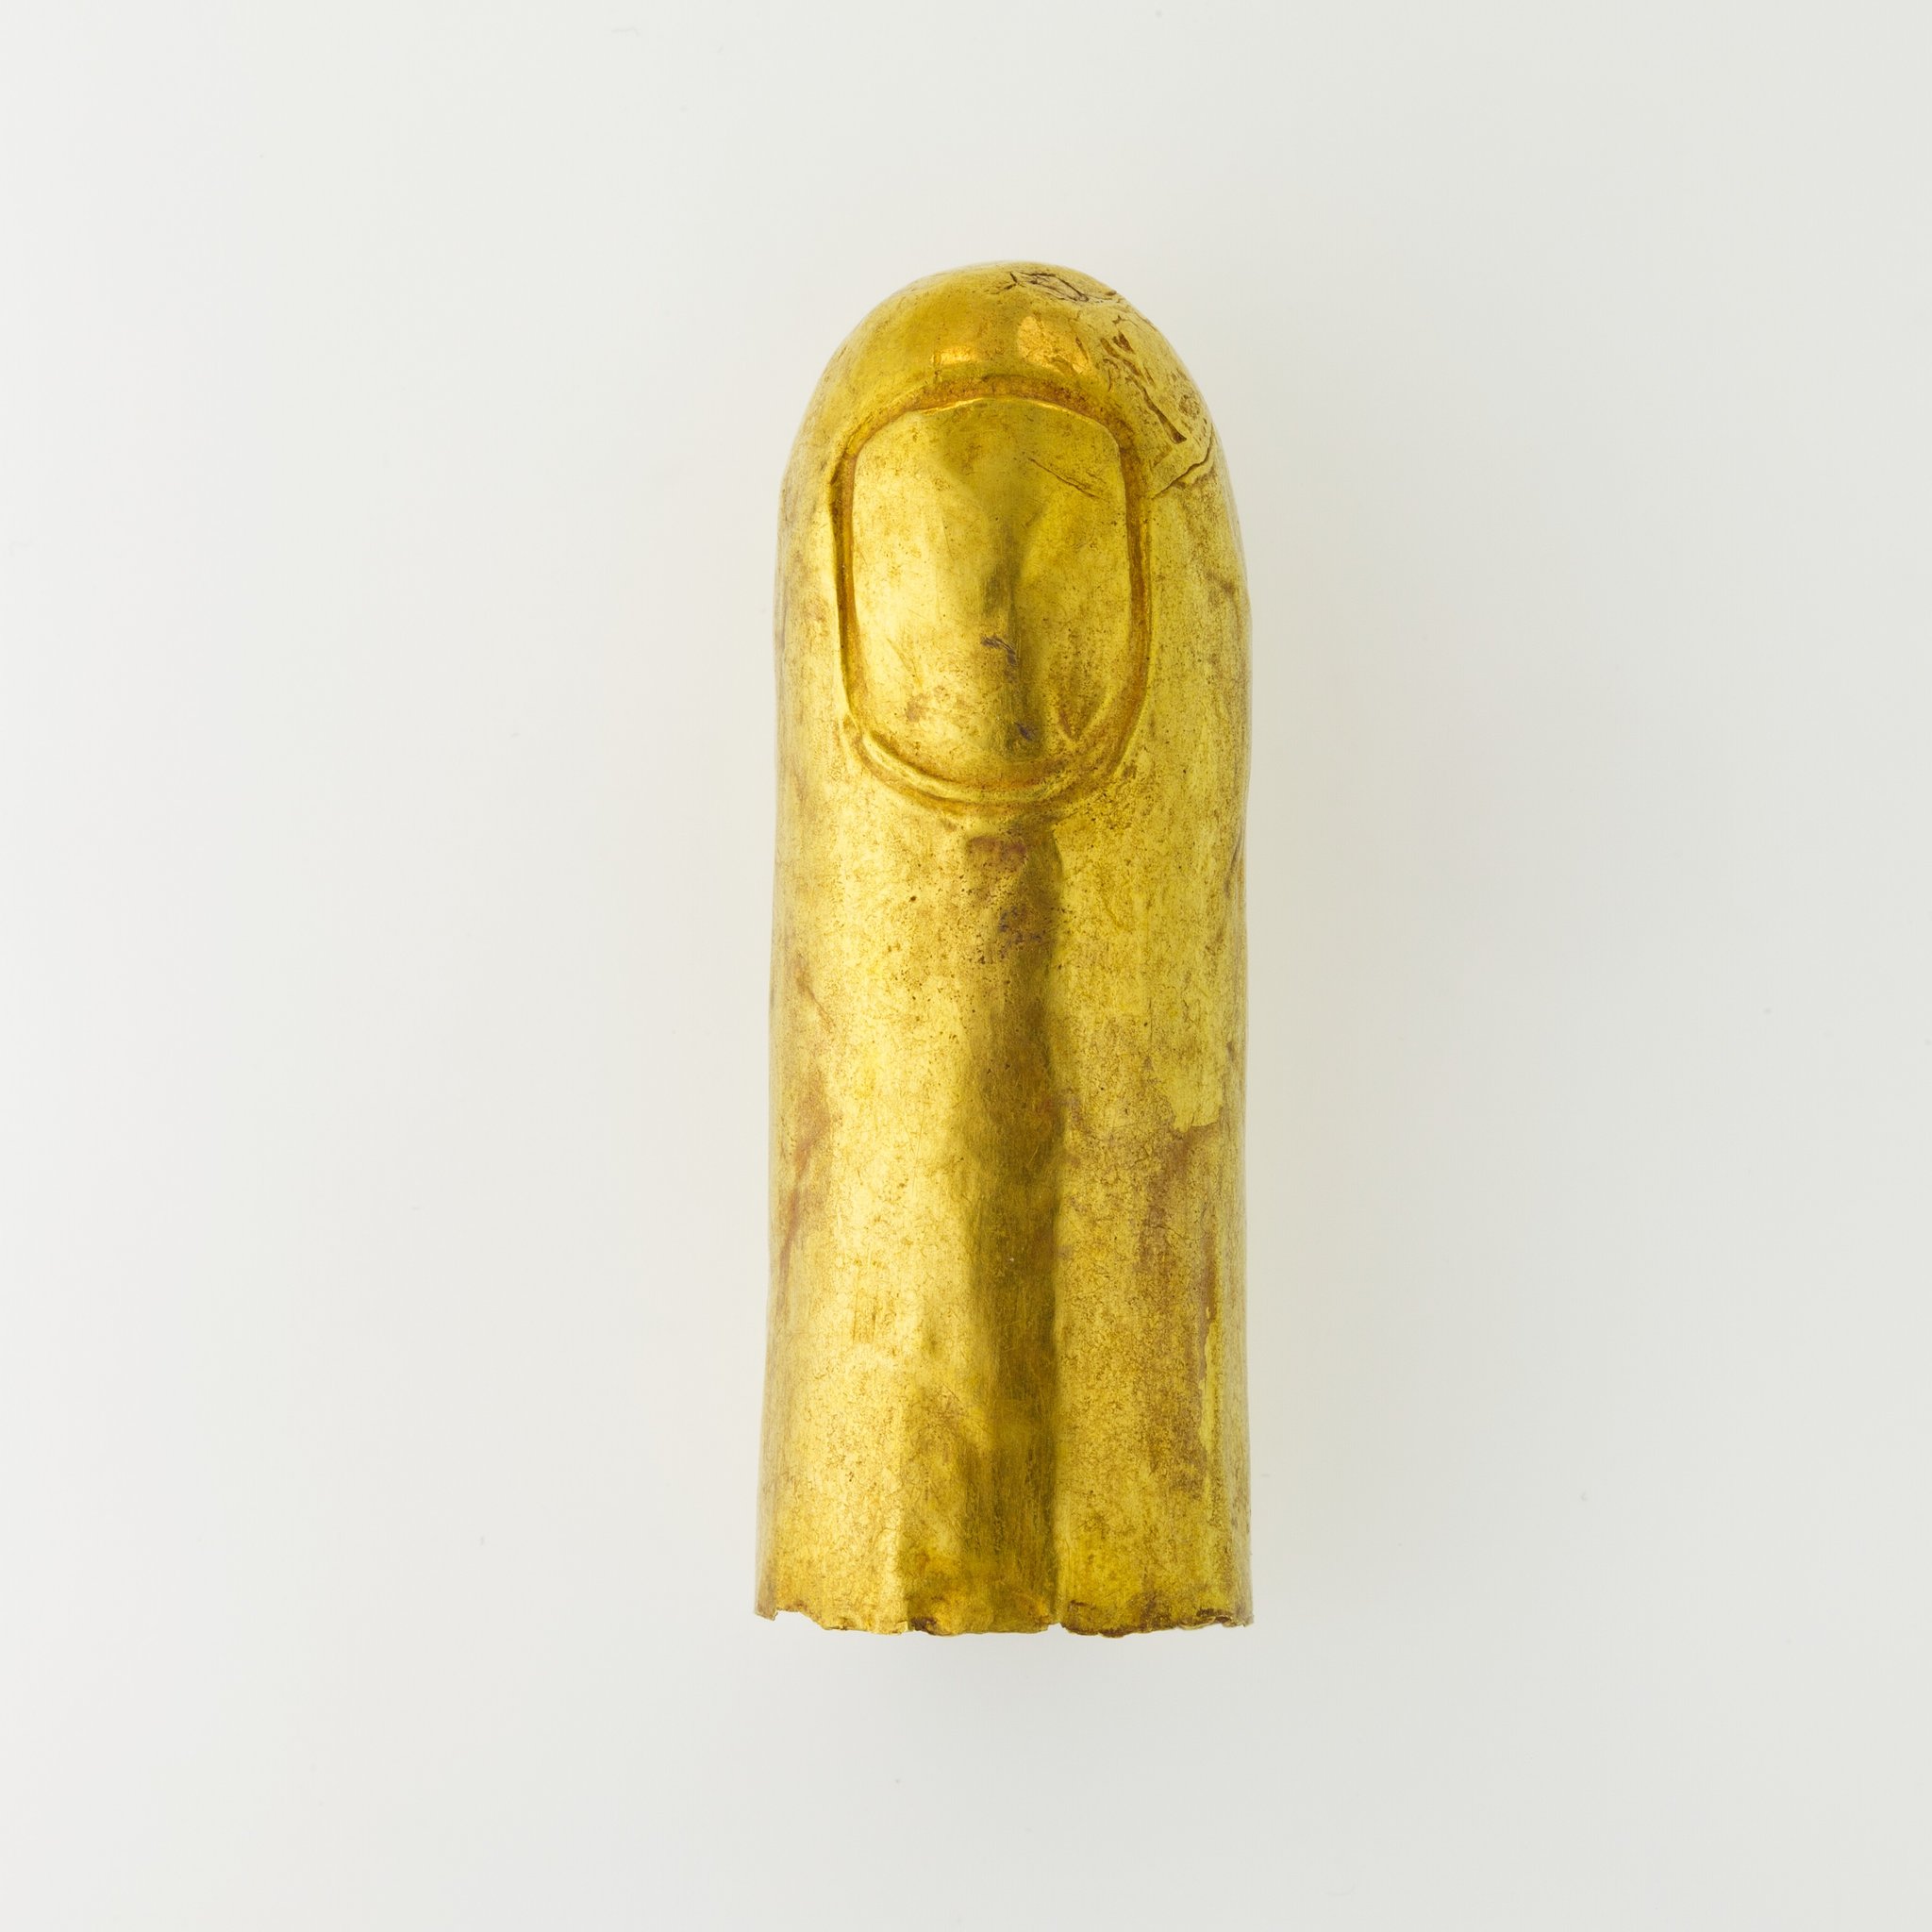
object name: finger stall, group 1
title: Finger stall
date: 1479-1425 BCE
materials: gold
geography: egypt